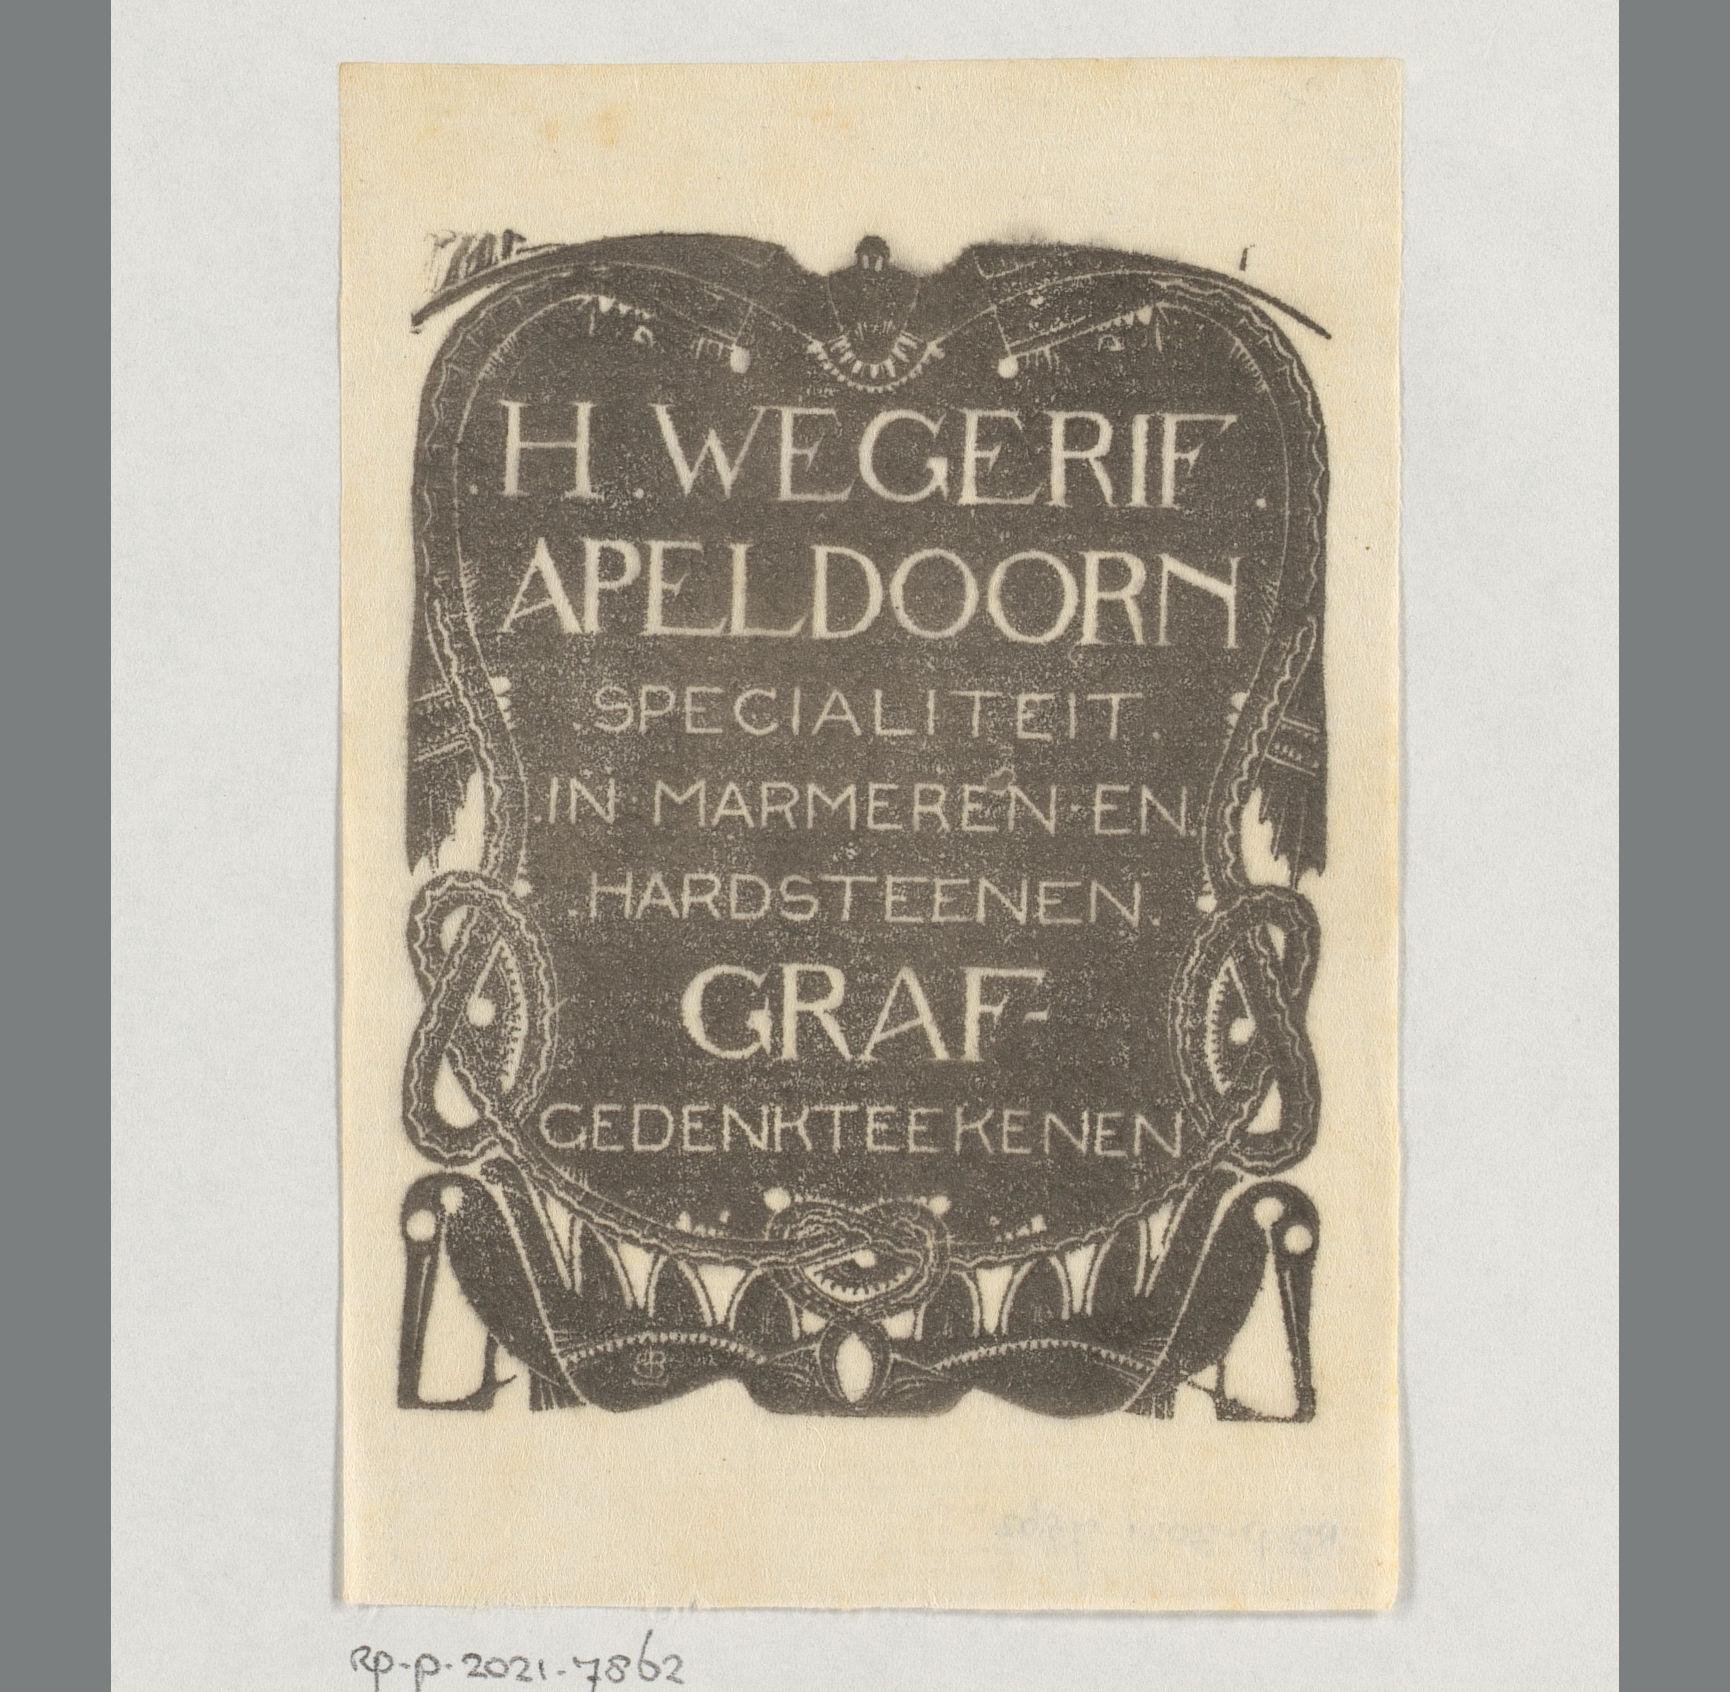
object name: advertisement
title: Advertentie voor steenhouwerij H. Wegerif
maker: mathieu lauweriks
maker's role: designer, draughtsman, print maker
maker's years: 1864-1932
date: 1874-1932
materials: paper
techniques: woodcut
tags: sculptor, ornaments ~ art, visiting-card, calling-card, fancy letters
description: In een decoratief kader: 'H. Wegerif Apeldoorn specialiteit in marmeren en hardsteenen graf-gedenkteekenen'.